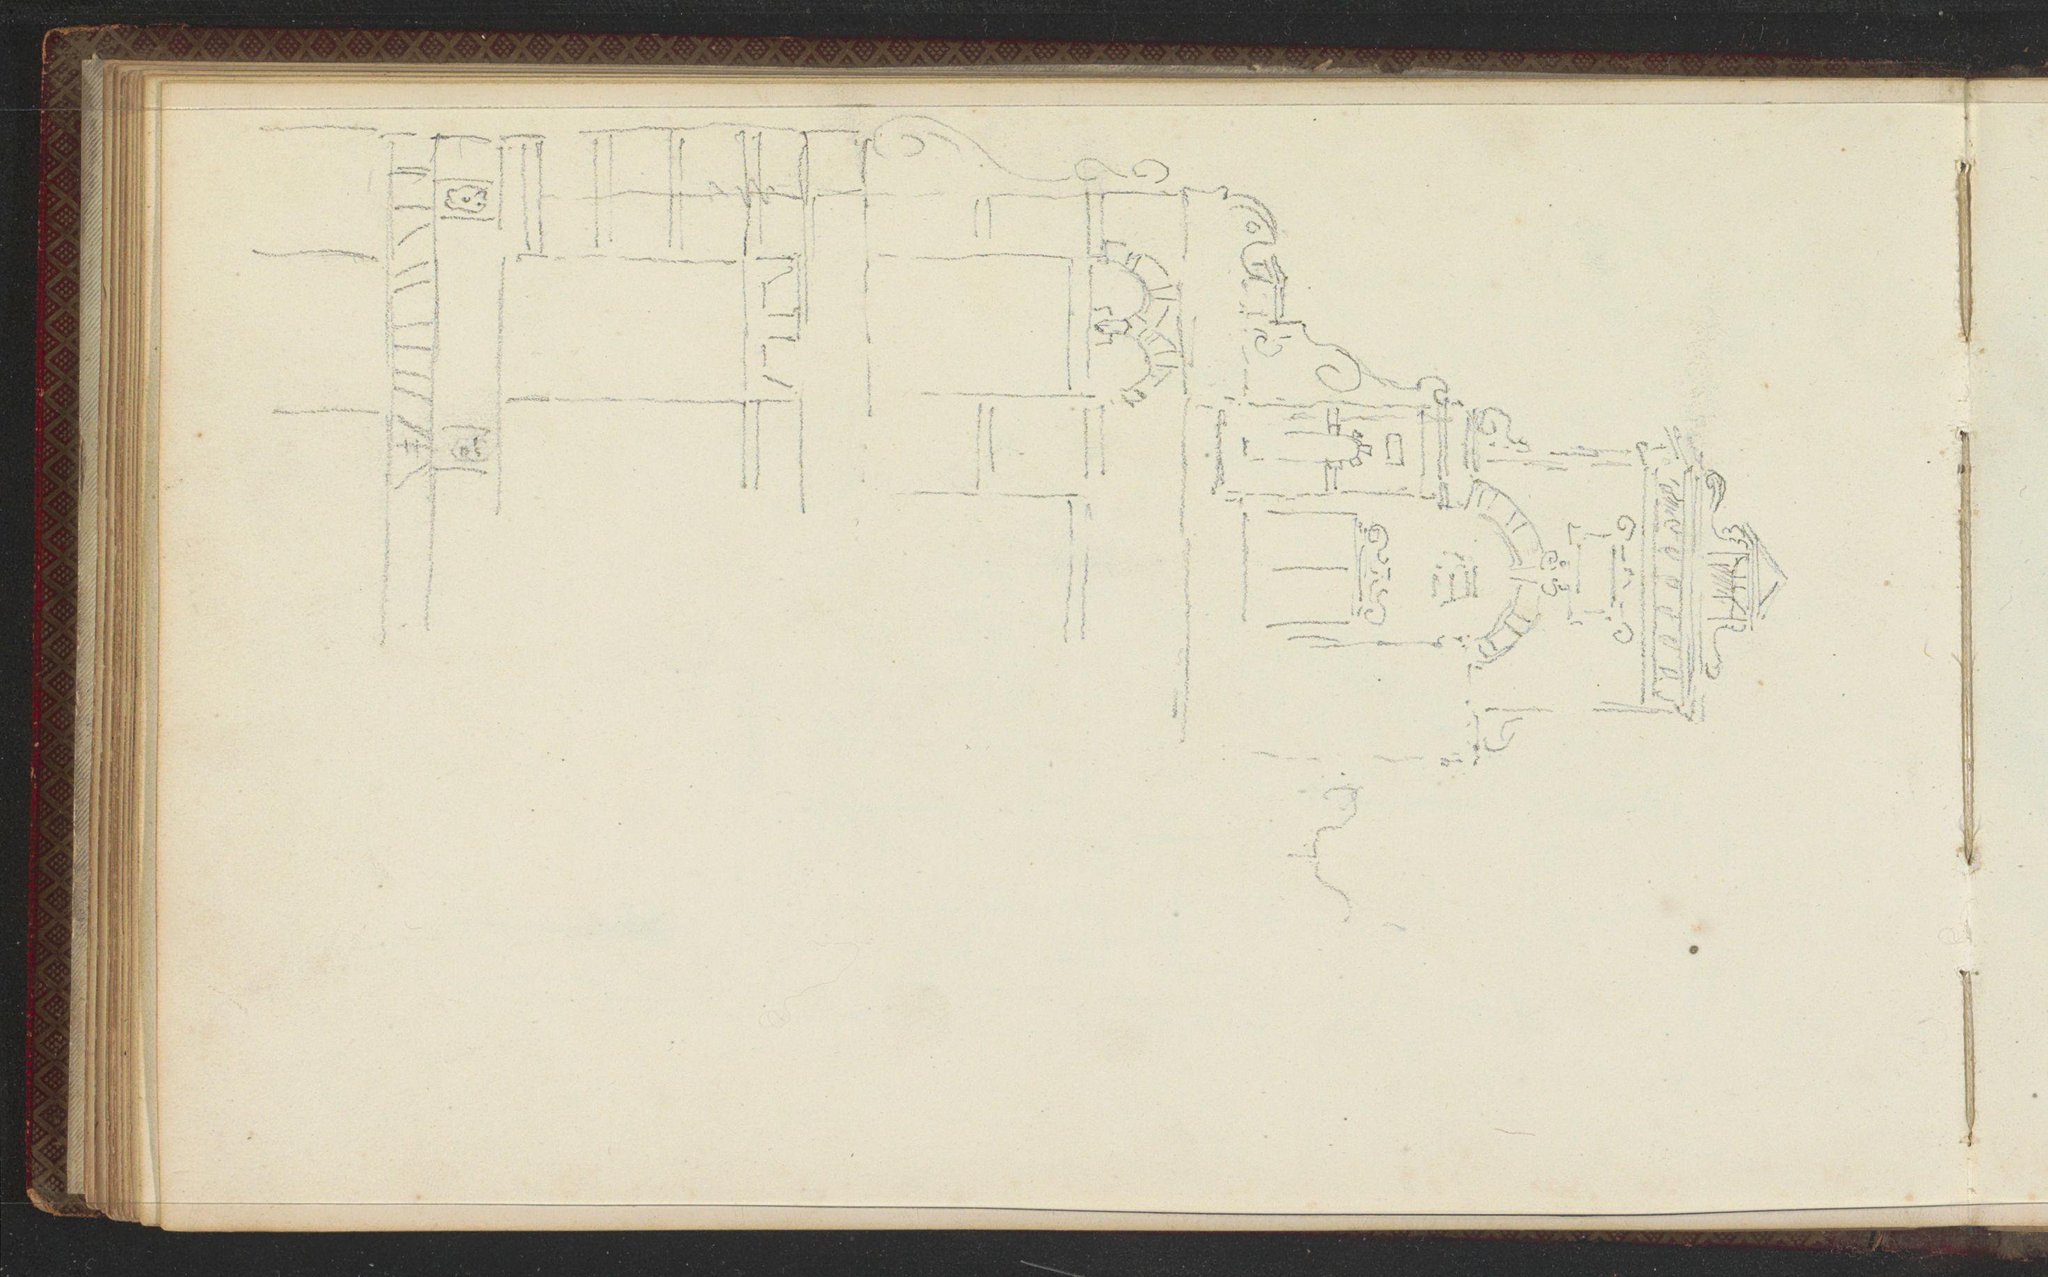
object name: sketchbook leaf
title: Gebouw met een verhoogde halsgevel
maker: adrianus eversen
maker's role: draughtsman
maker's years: 1818-1897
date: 1828-1897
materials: paper, pencil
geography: netherlands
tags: urban housing, decorated gable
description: Studie van een gebouw met een verhoogde halsgevel. Blad 33 verso uit een schetsboek met 52 bladen vervaardigd in de omgeving van Kampen, Hattem, Hoorn en Zwolle.